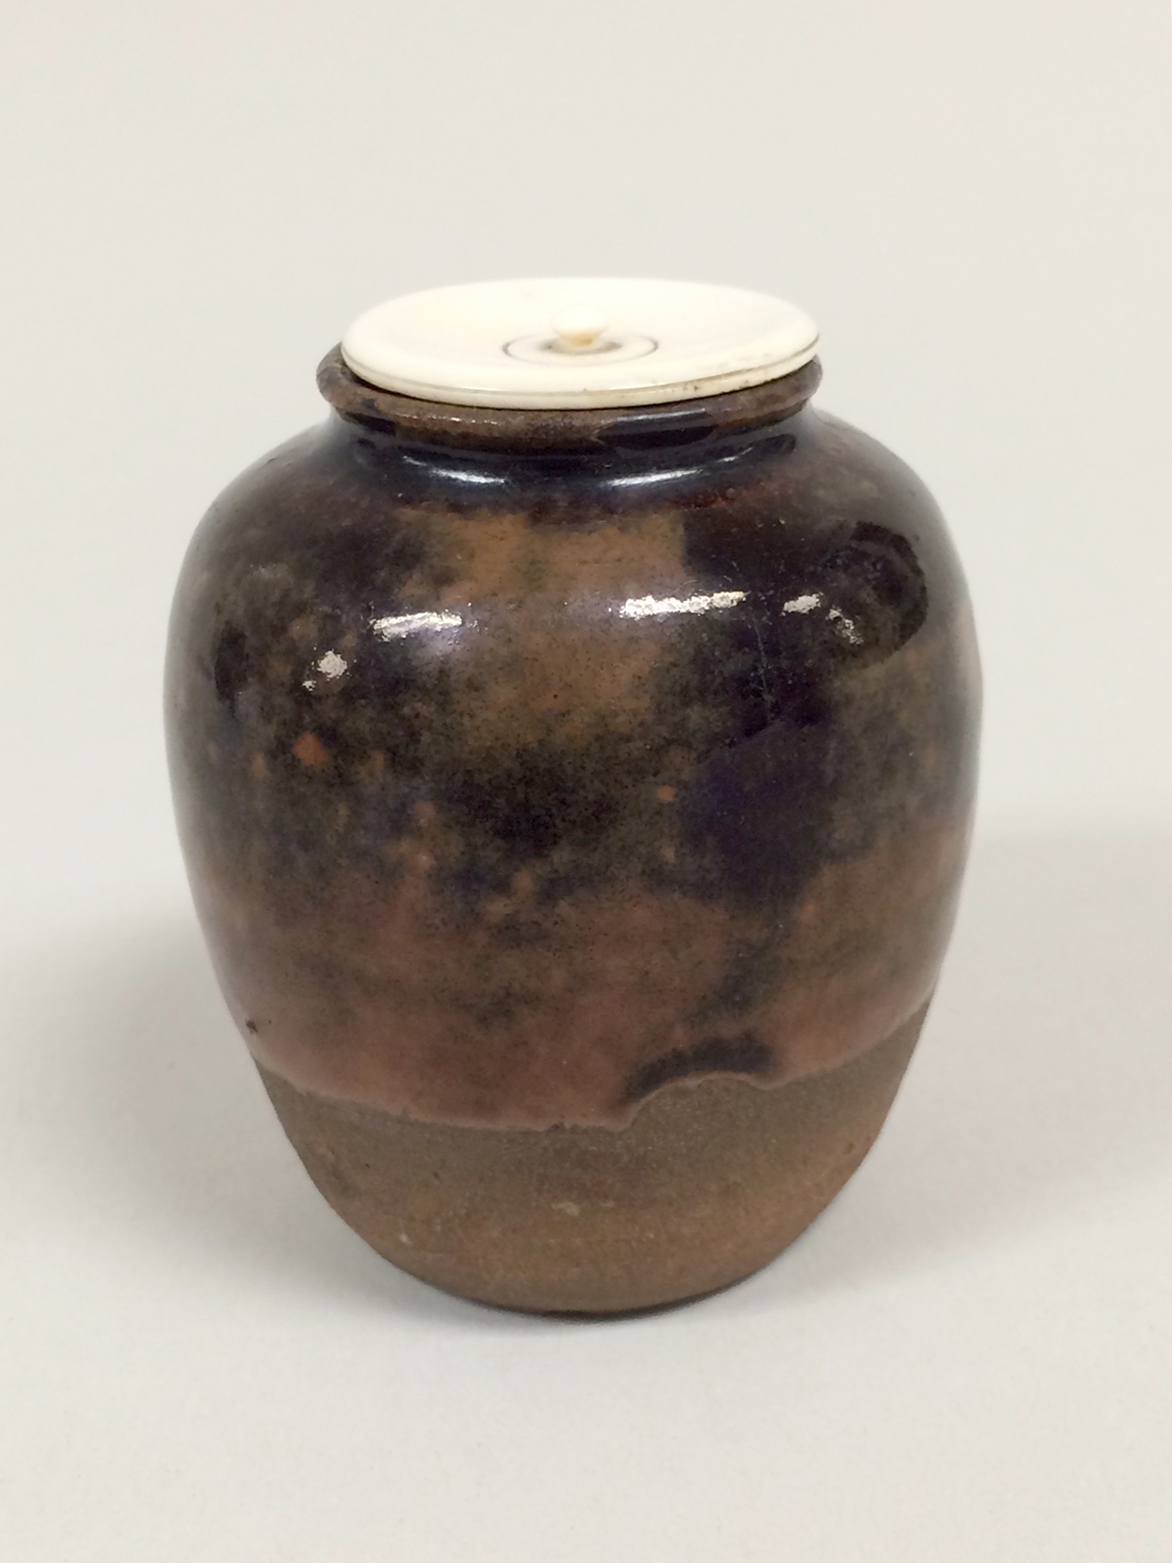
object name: tea jar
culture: japanese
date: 1601-1700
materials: clay, glaze